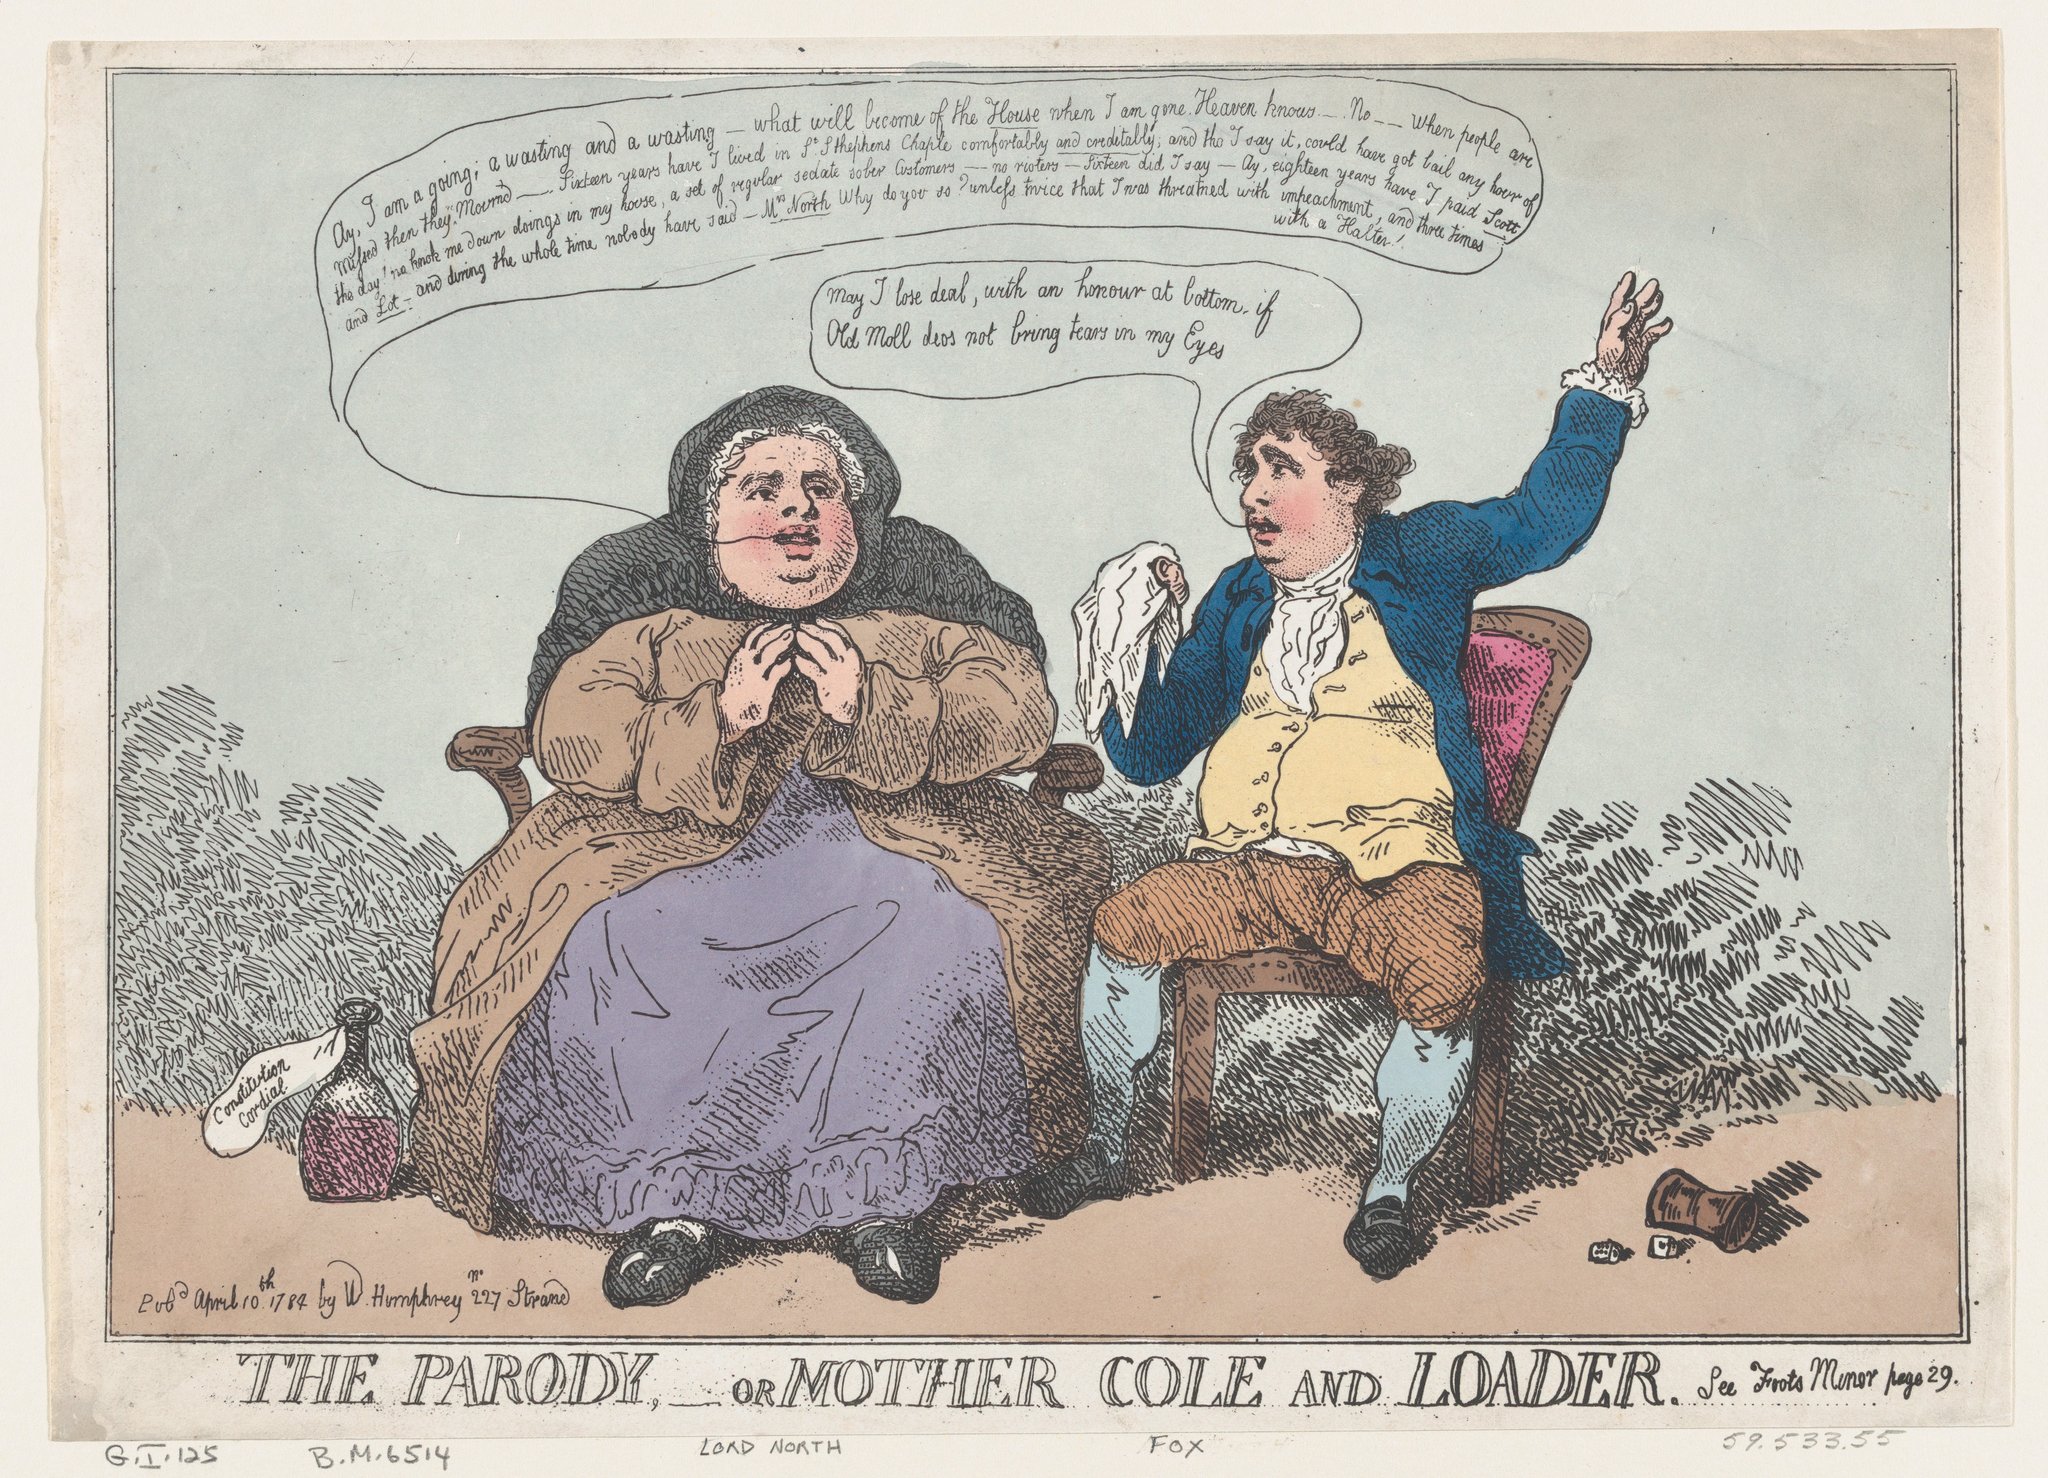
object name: print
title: The Parody, or Mother Cole and Loader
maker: thomas rowlandson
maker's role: artist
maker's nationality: british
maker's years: 1757-1827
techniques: etching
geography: london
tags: men,mothers